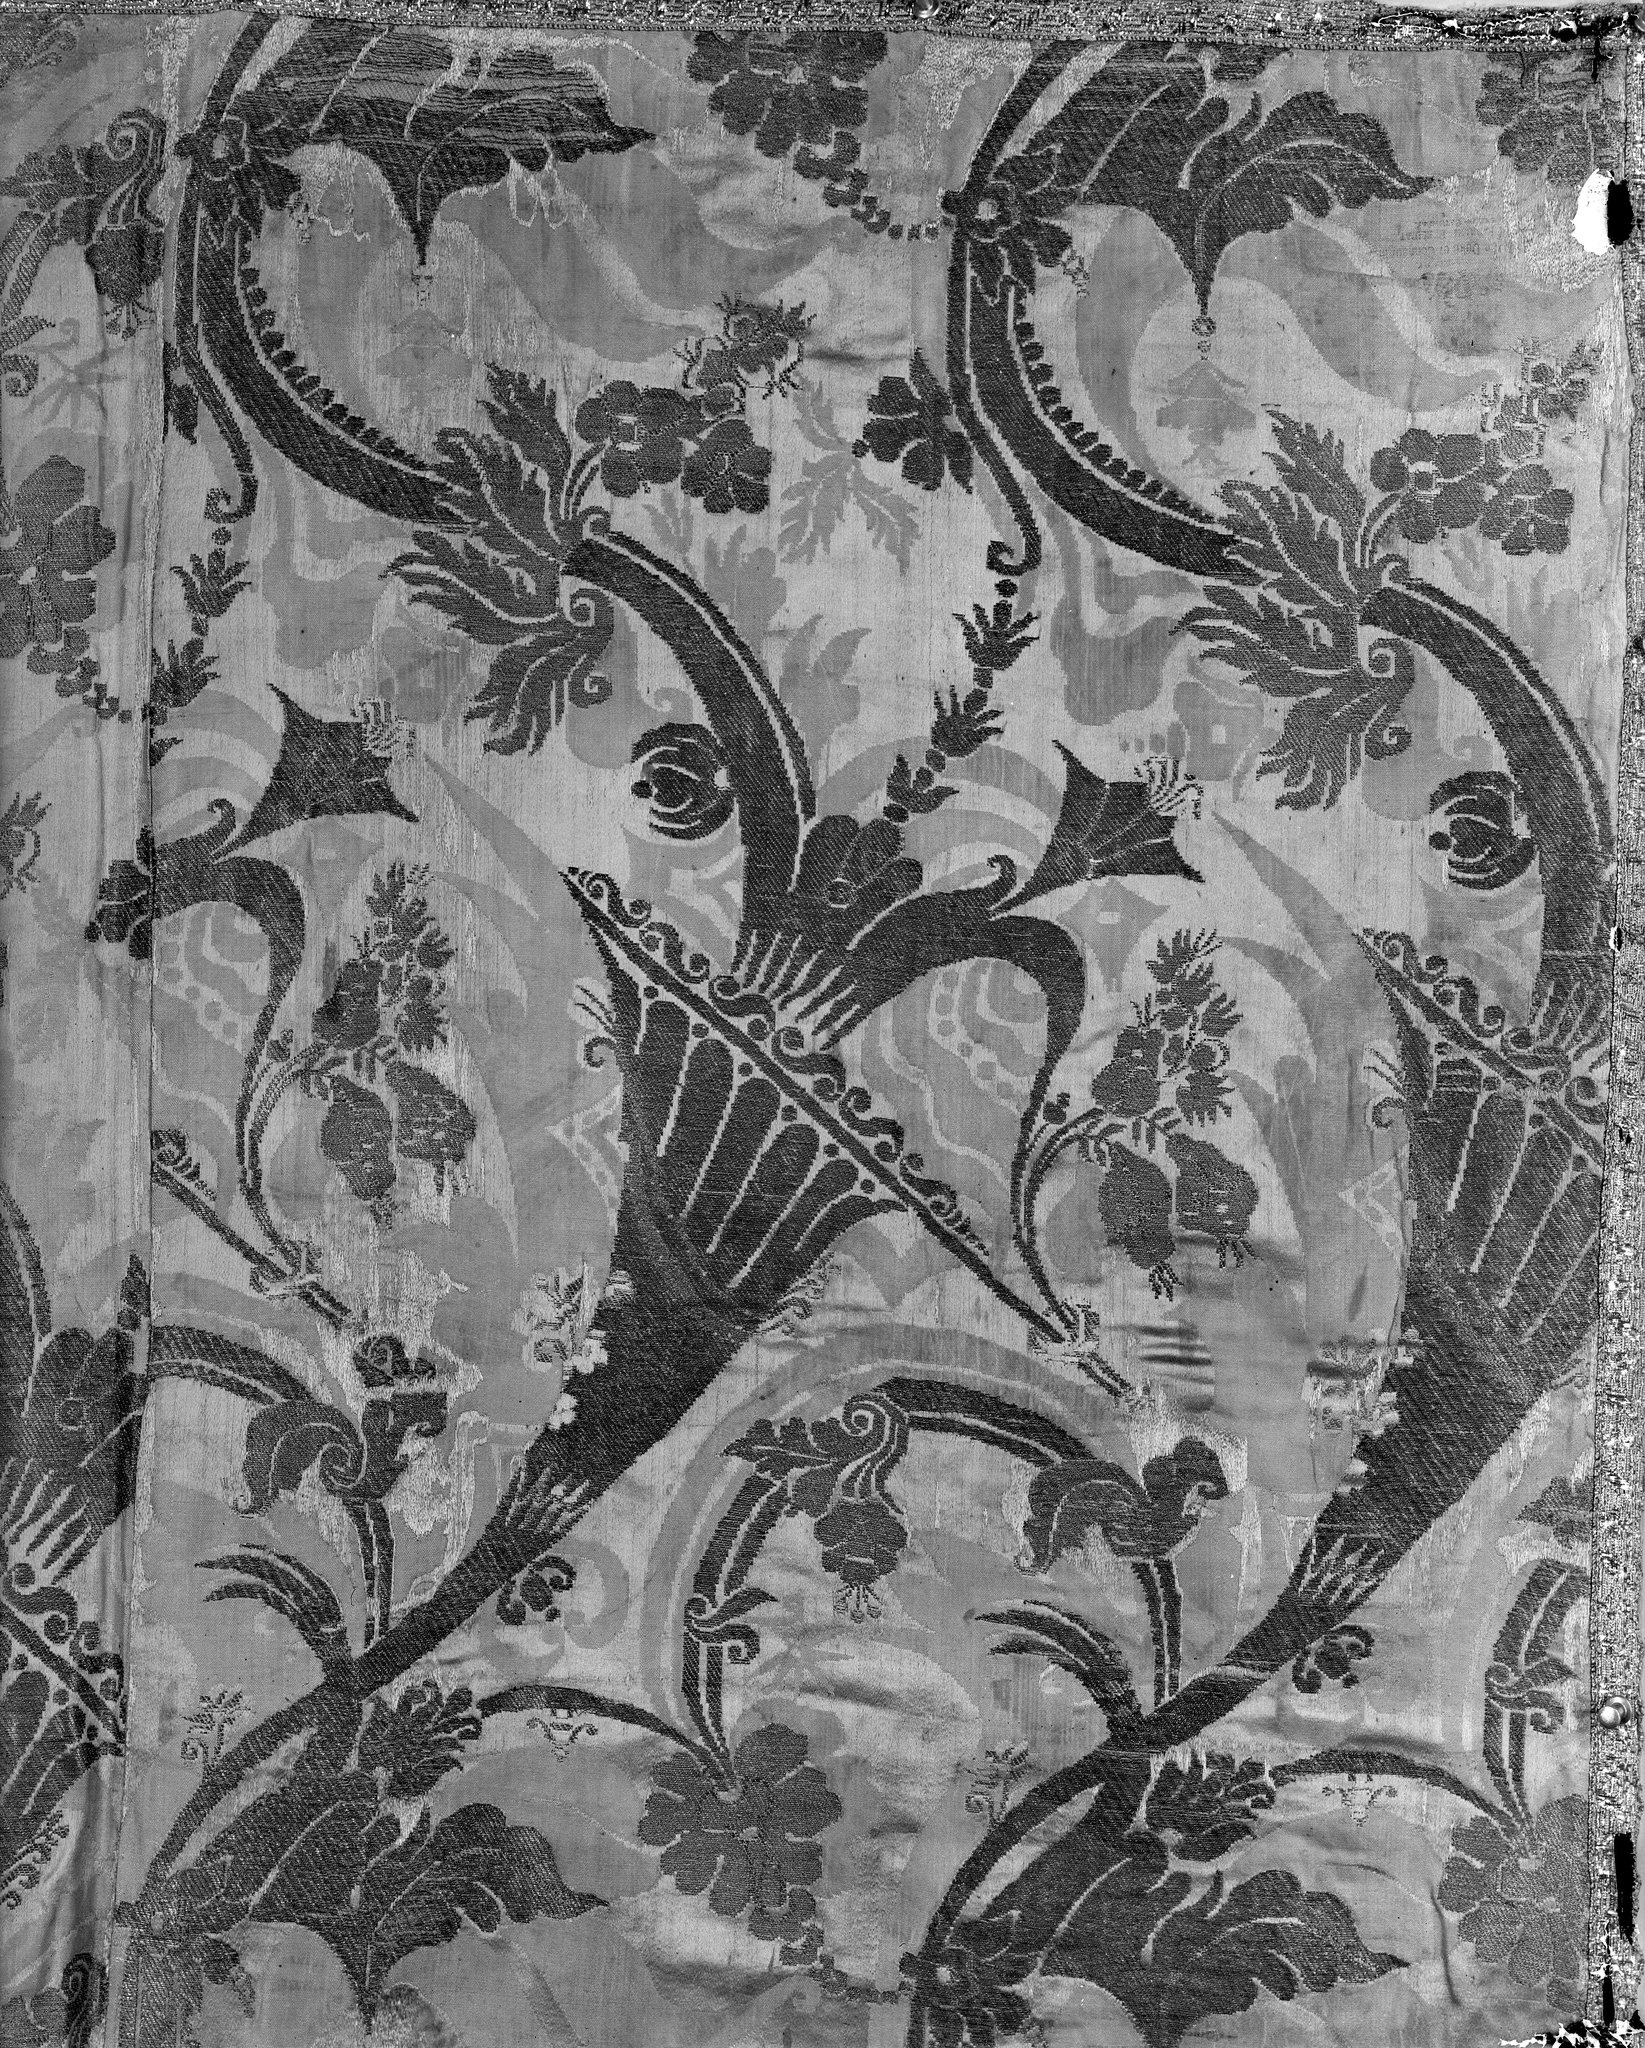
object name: piece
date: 1700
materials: metal thread, silk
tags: flowers